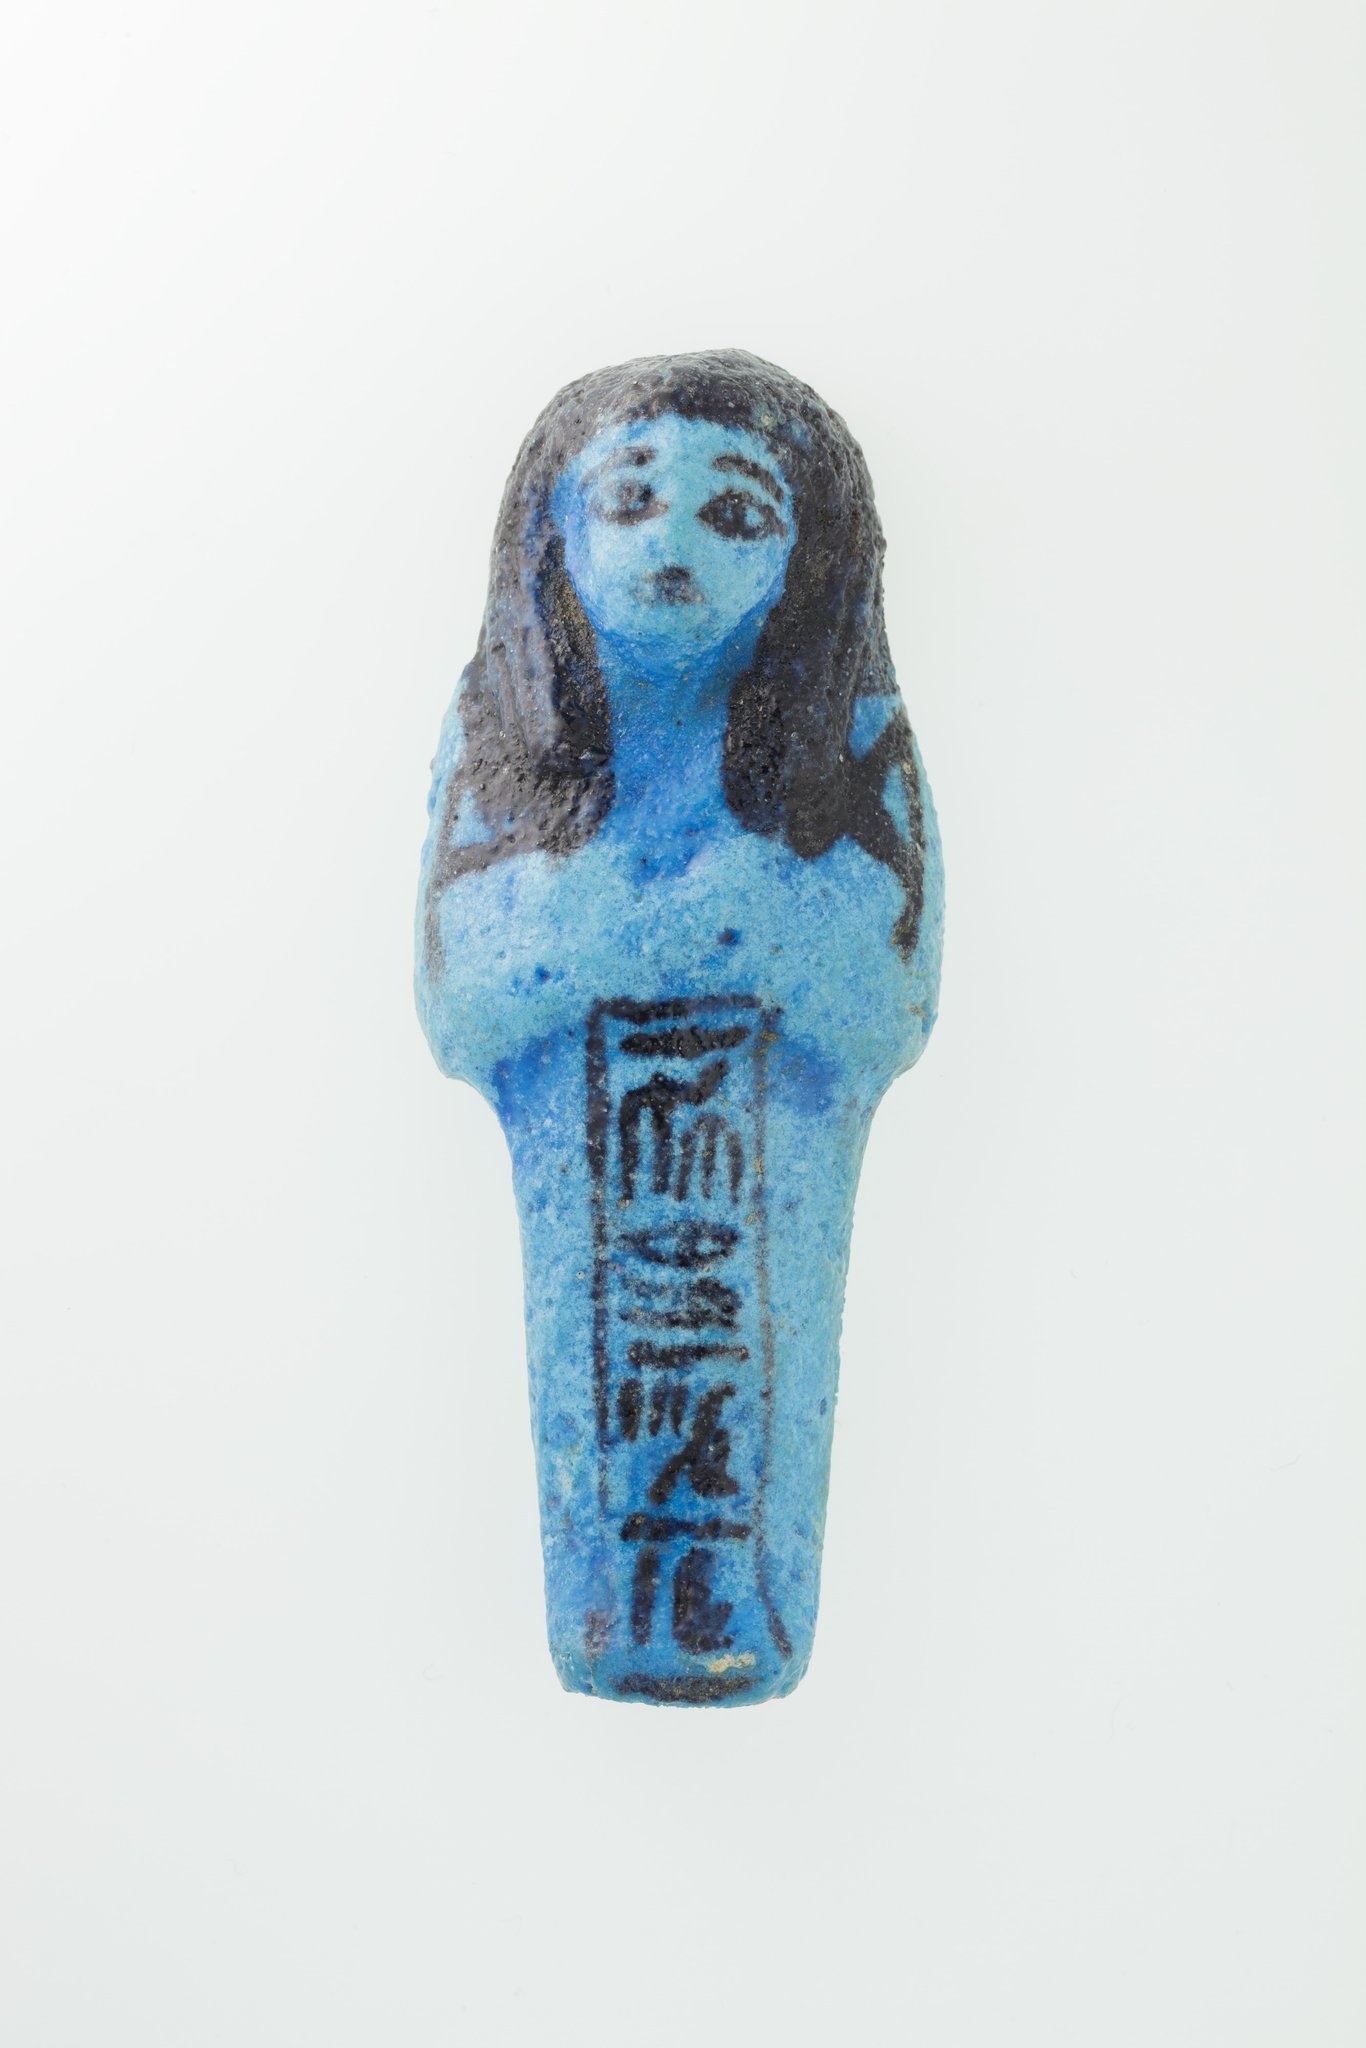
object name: shabti, worker, nauny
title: Worker Shabti of Nauny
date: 1050 BCE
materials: faience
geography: egypt